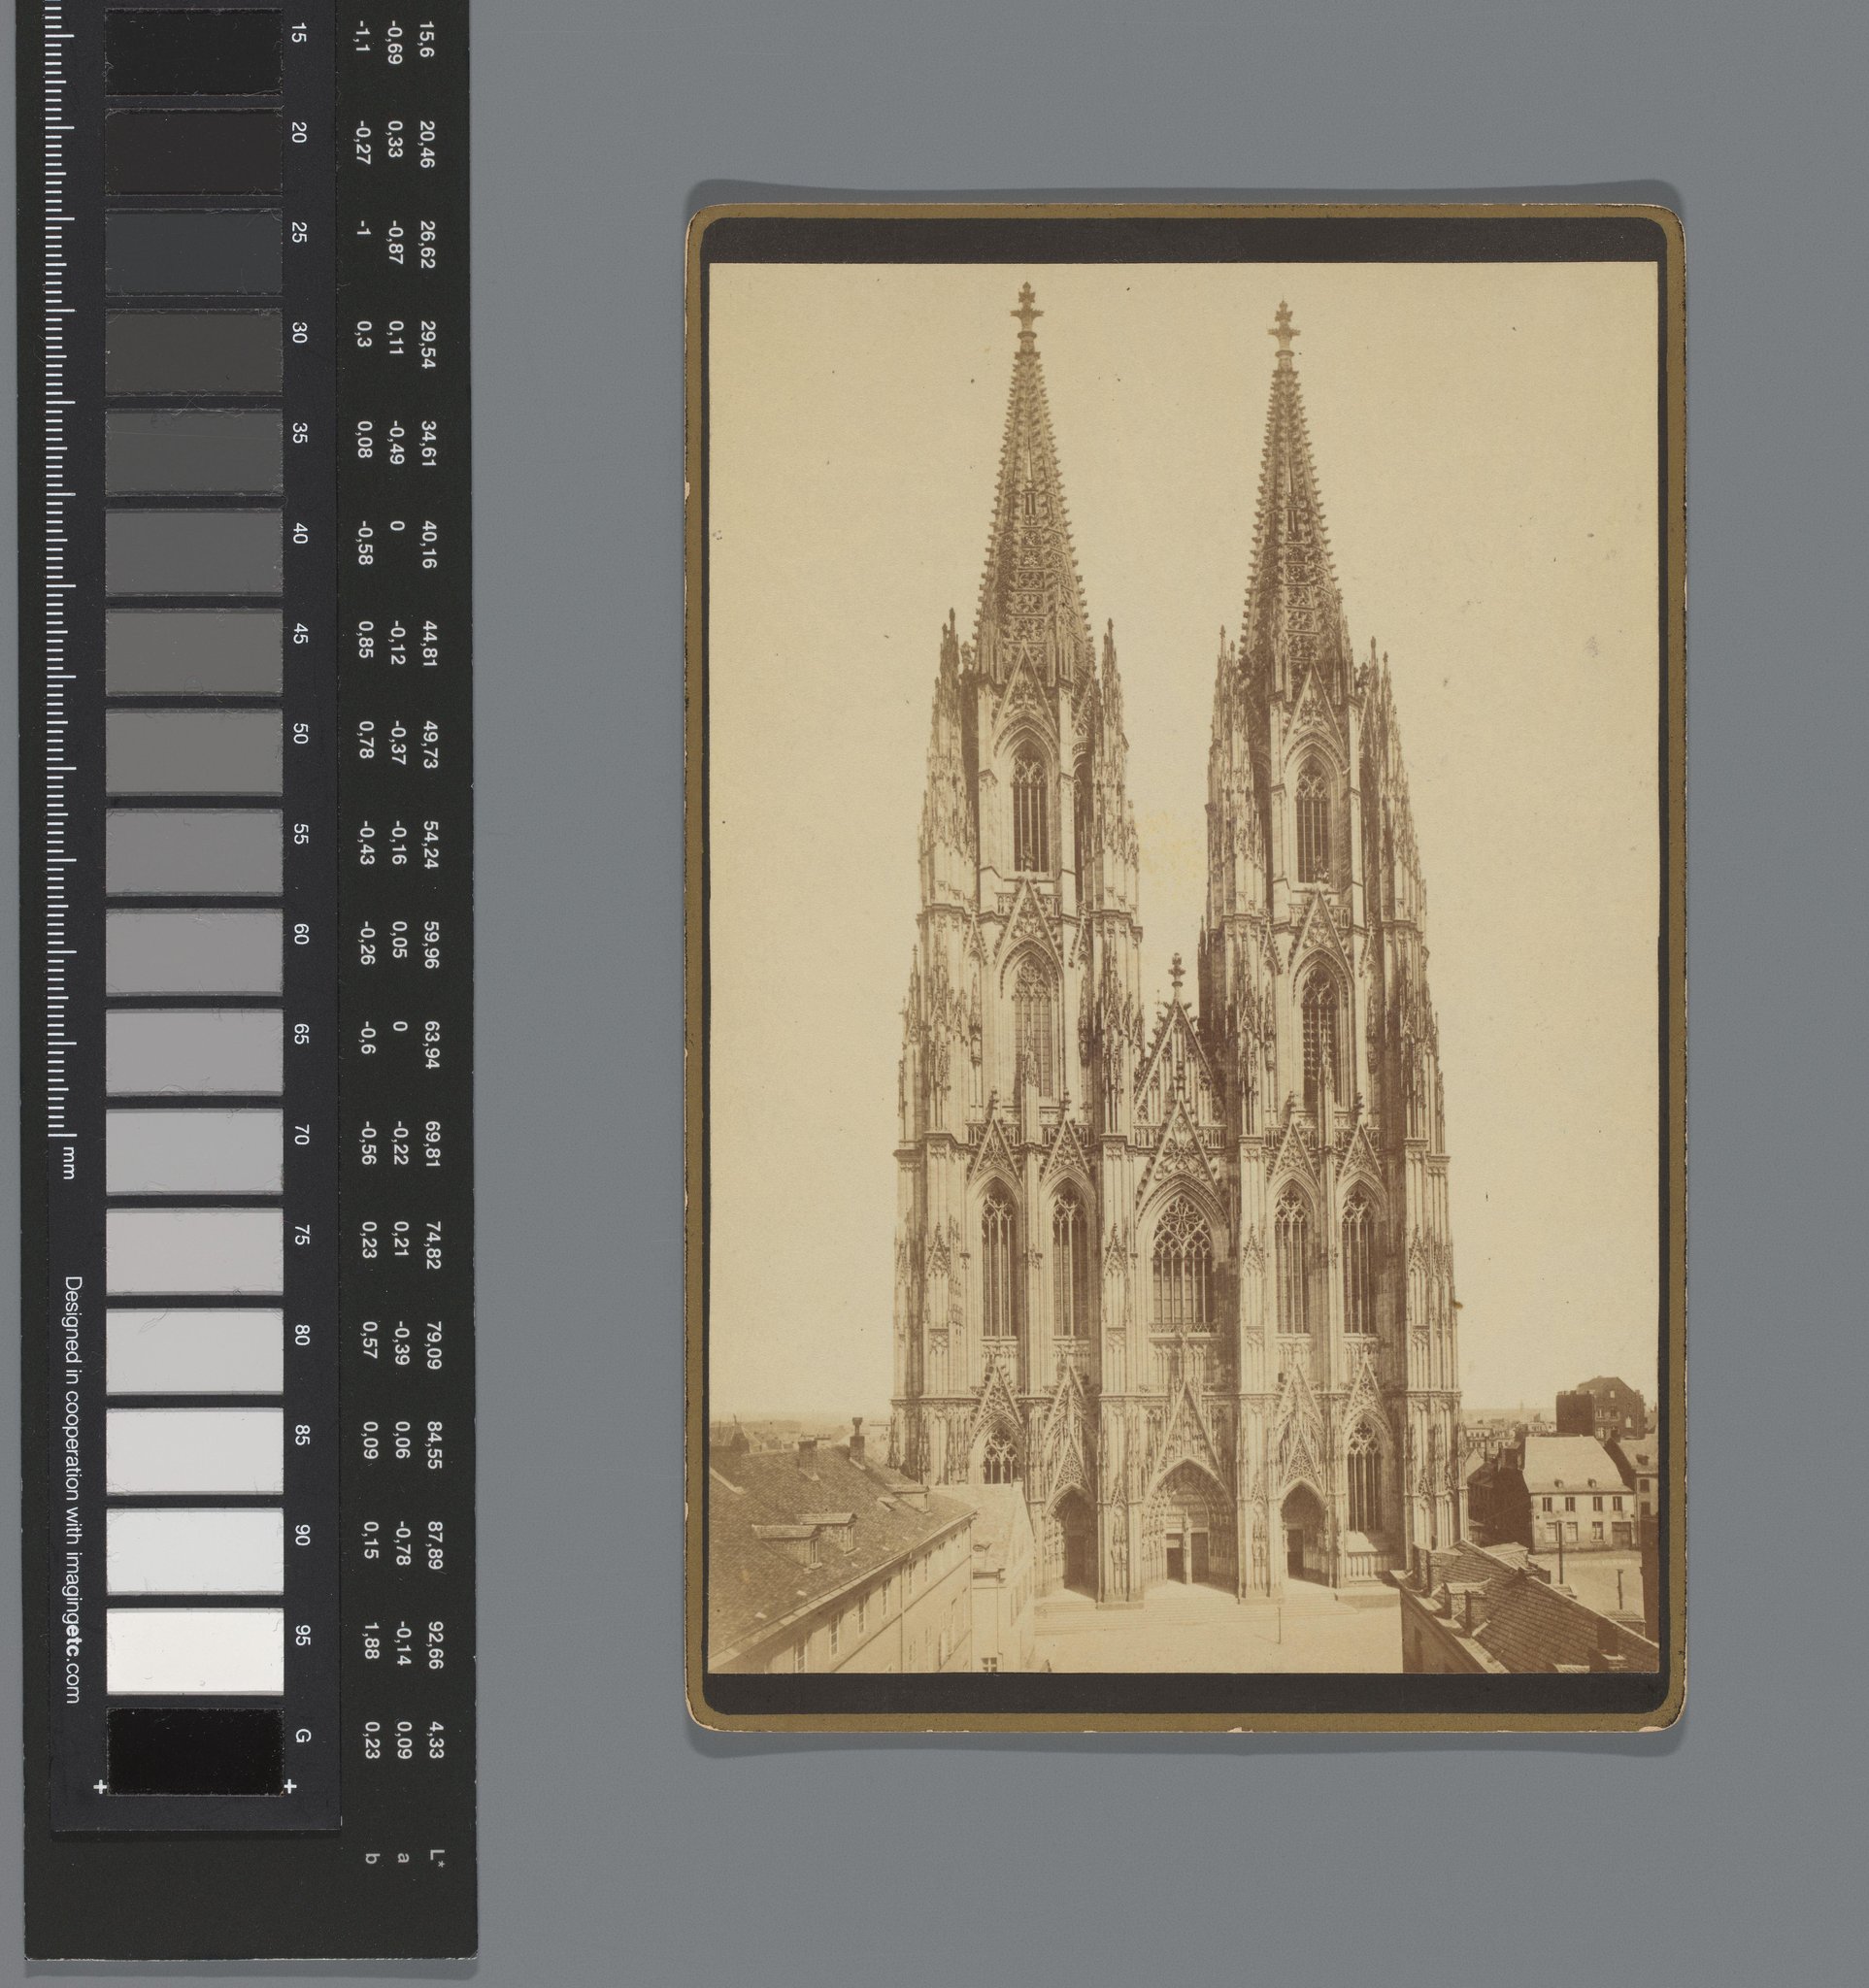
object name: photograph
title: Köln. Domkloster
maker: Anonymous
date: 1850-1880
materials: photographic support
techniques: albumen print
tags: dom van keulen